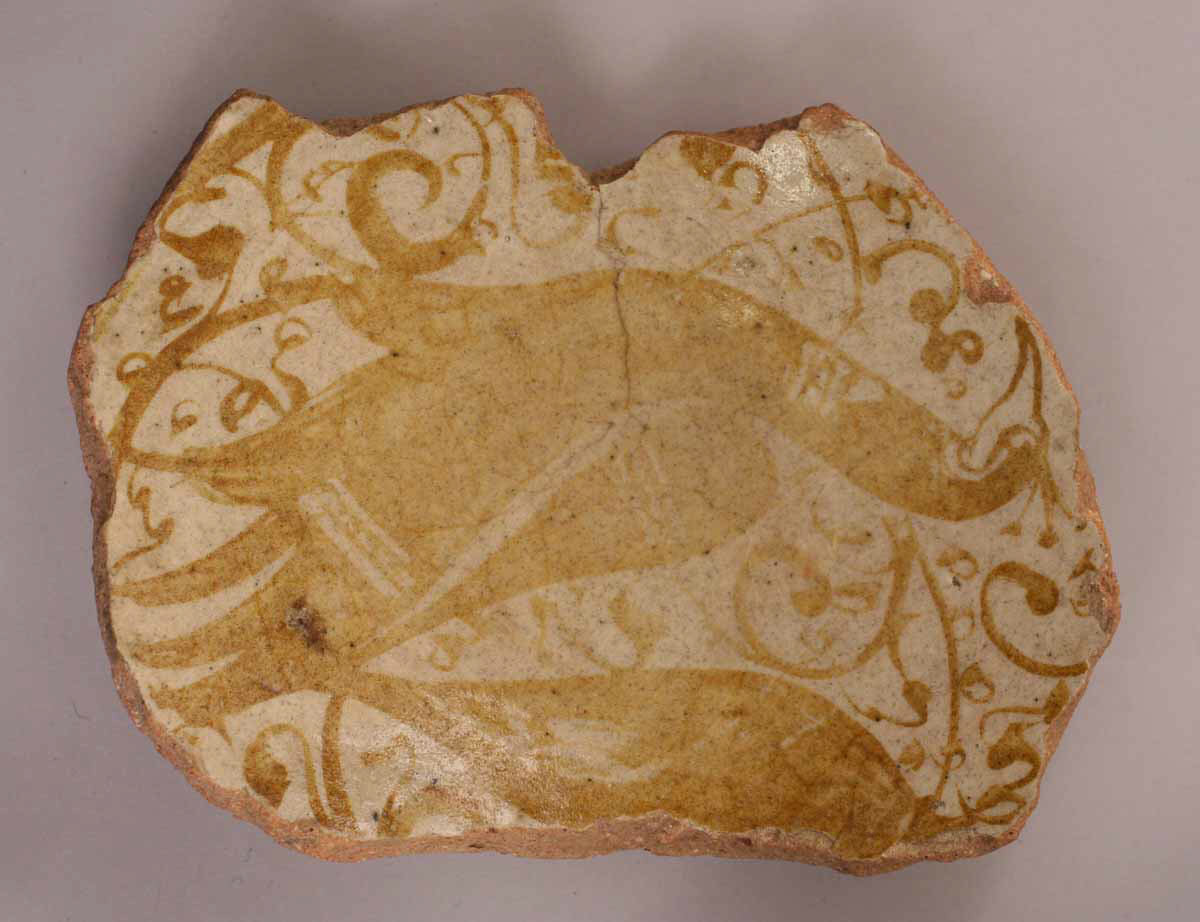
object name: fragment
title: Ceramic Fragment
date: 1101-1200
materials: glaze, stonepaste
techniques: painting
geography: syria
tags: birds